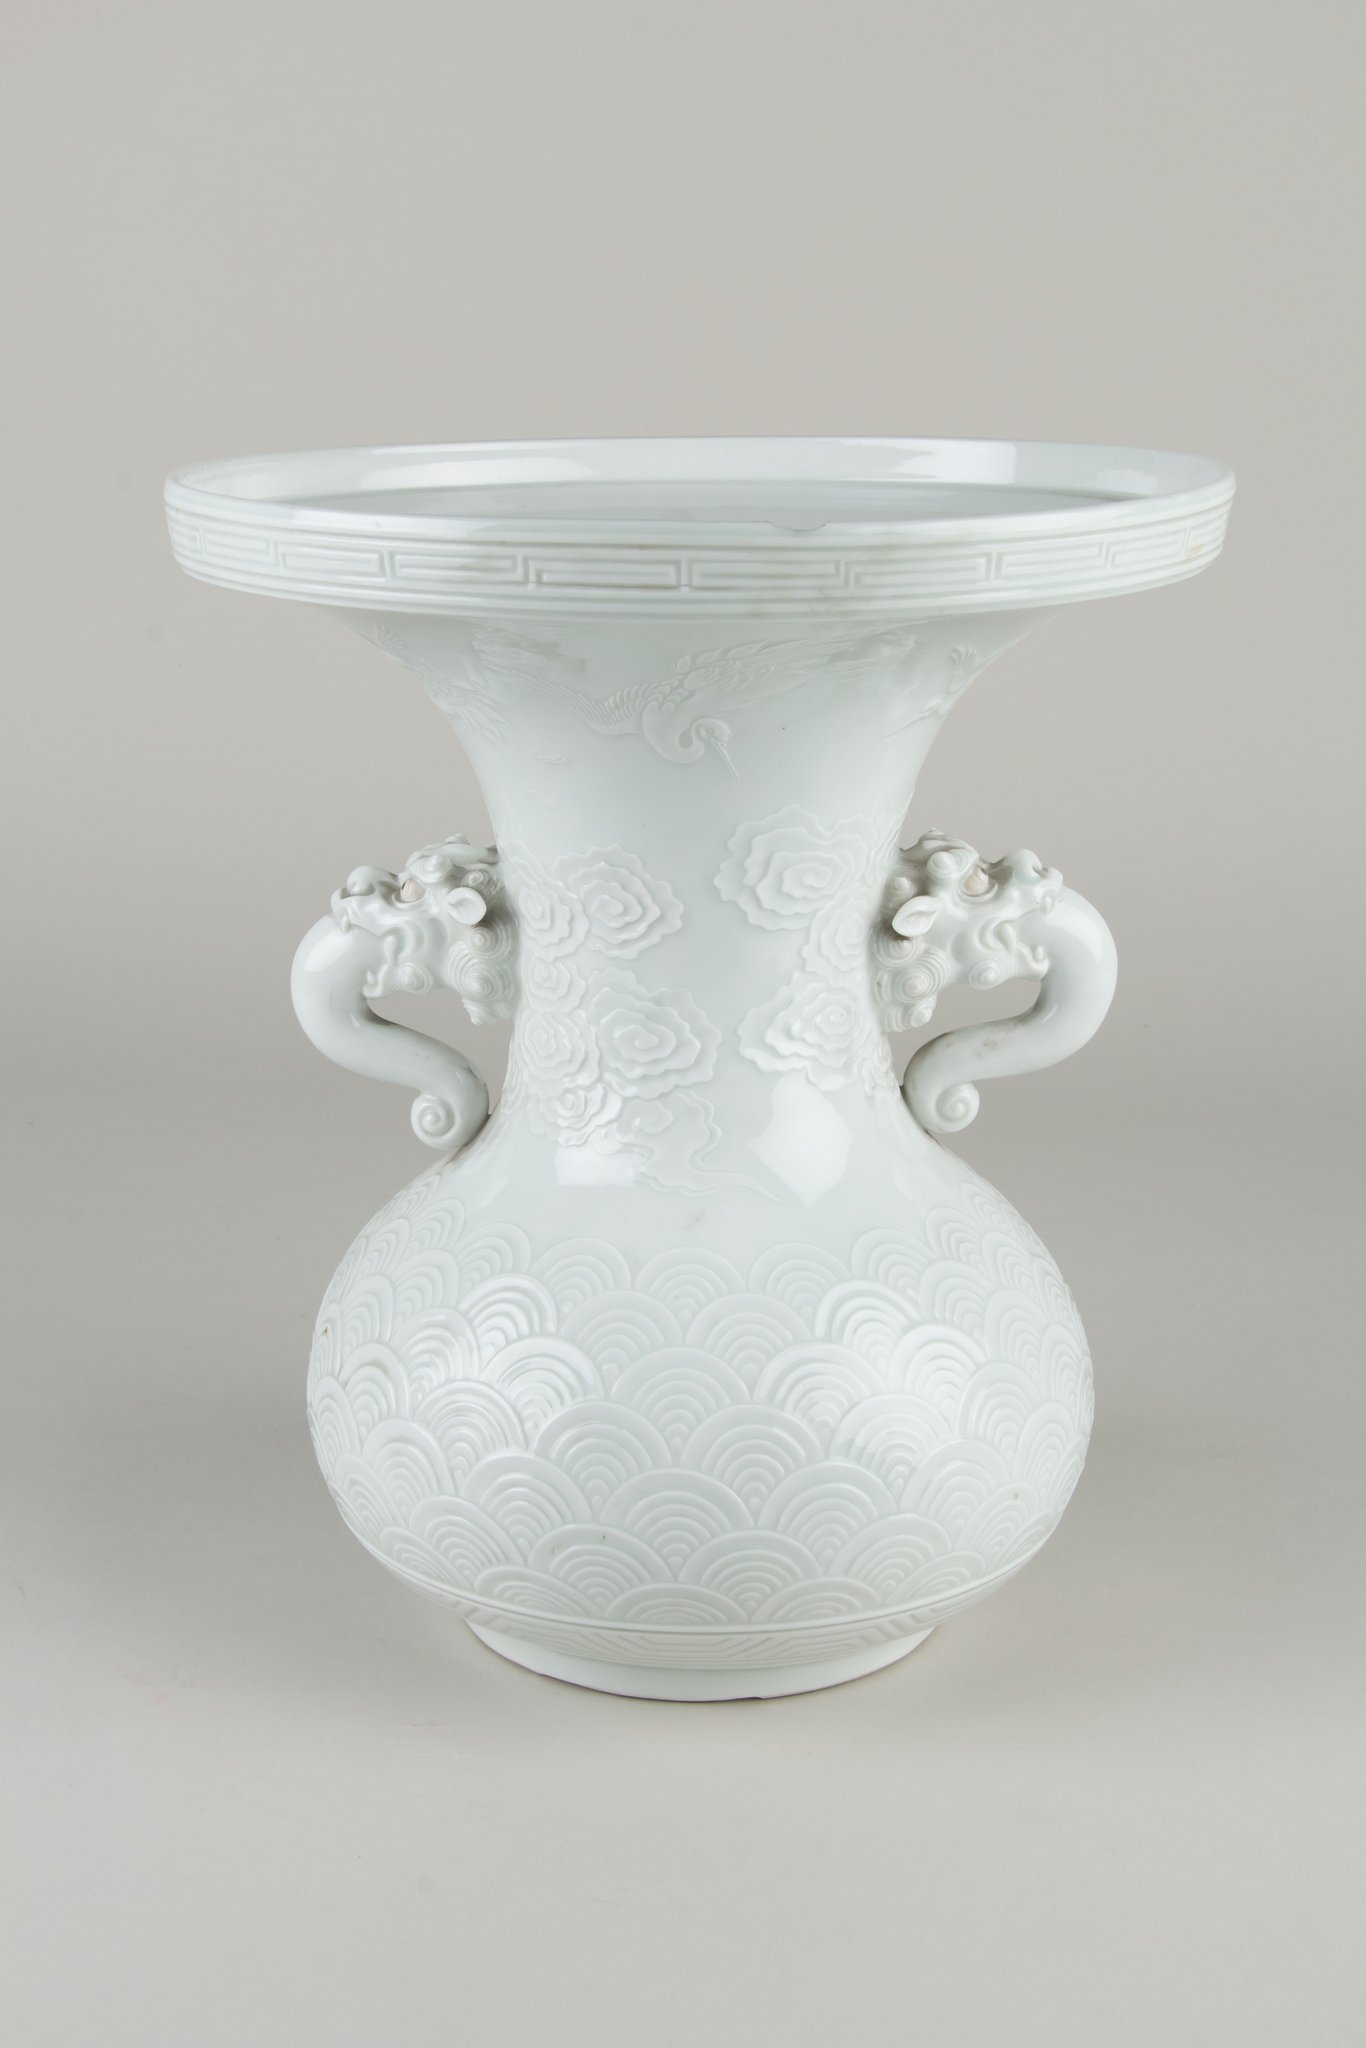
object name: vase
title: Vase with Lion-Shaped Handles and Cranes amid Clouds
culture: japanese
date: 1801-1850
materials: porcelain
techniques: relief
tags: cranes,lions